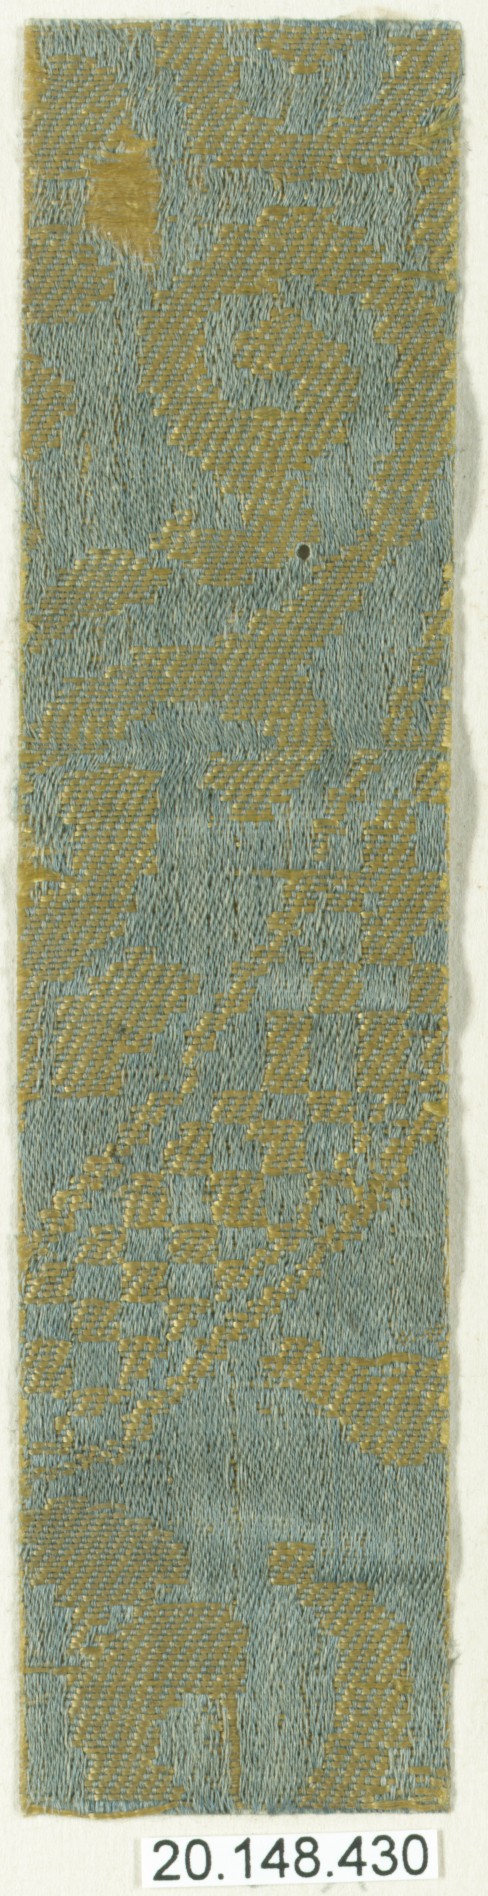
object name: piece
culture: japanese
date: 1701-1800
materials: silk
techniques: compound weave